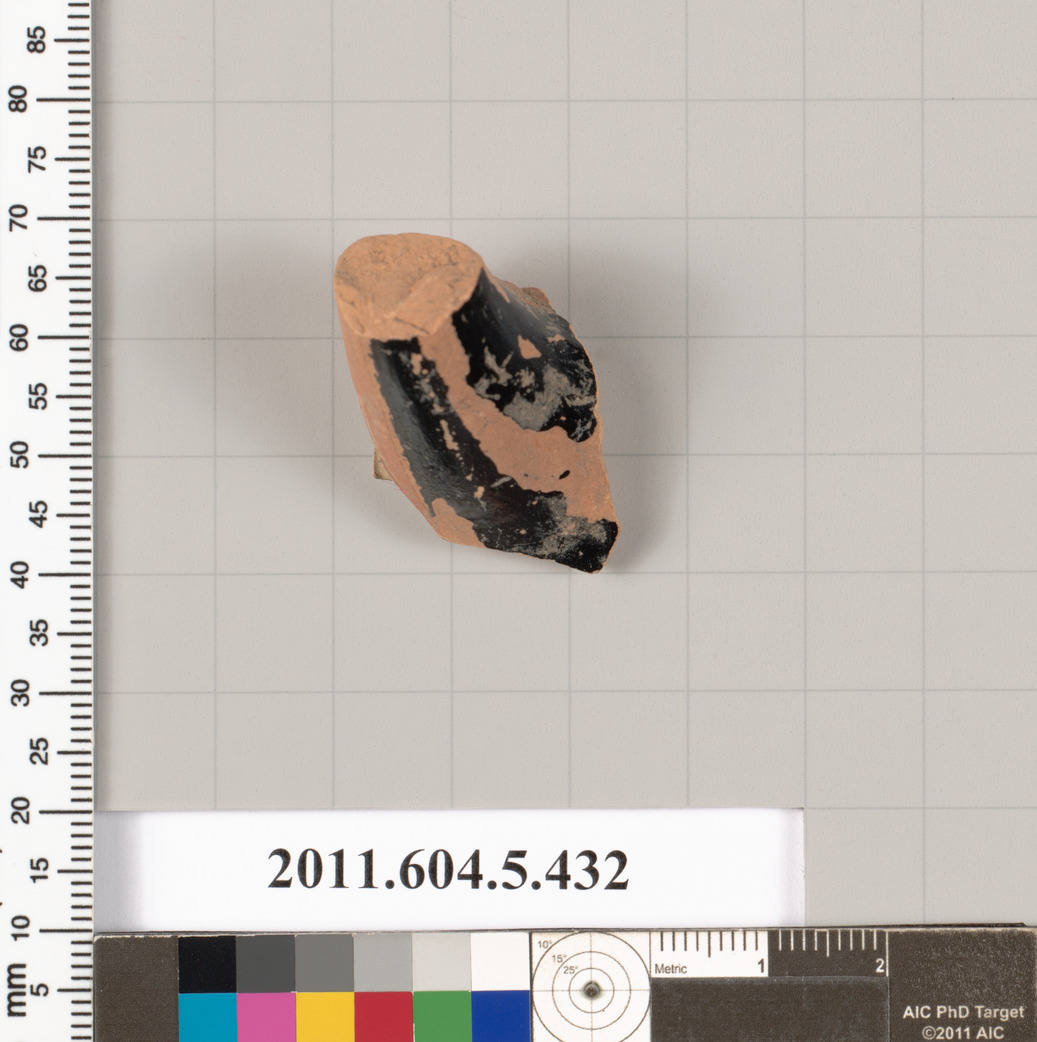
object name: kylix fragment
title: Terracotta fragment of a kylix (drinking cup)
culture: greek, attic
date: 600-401 BCE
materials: terracotta